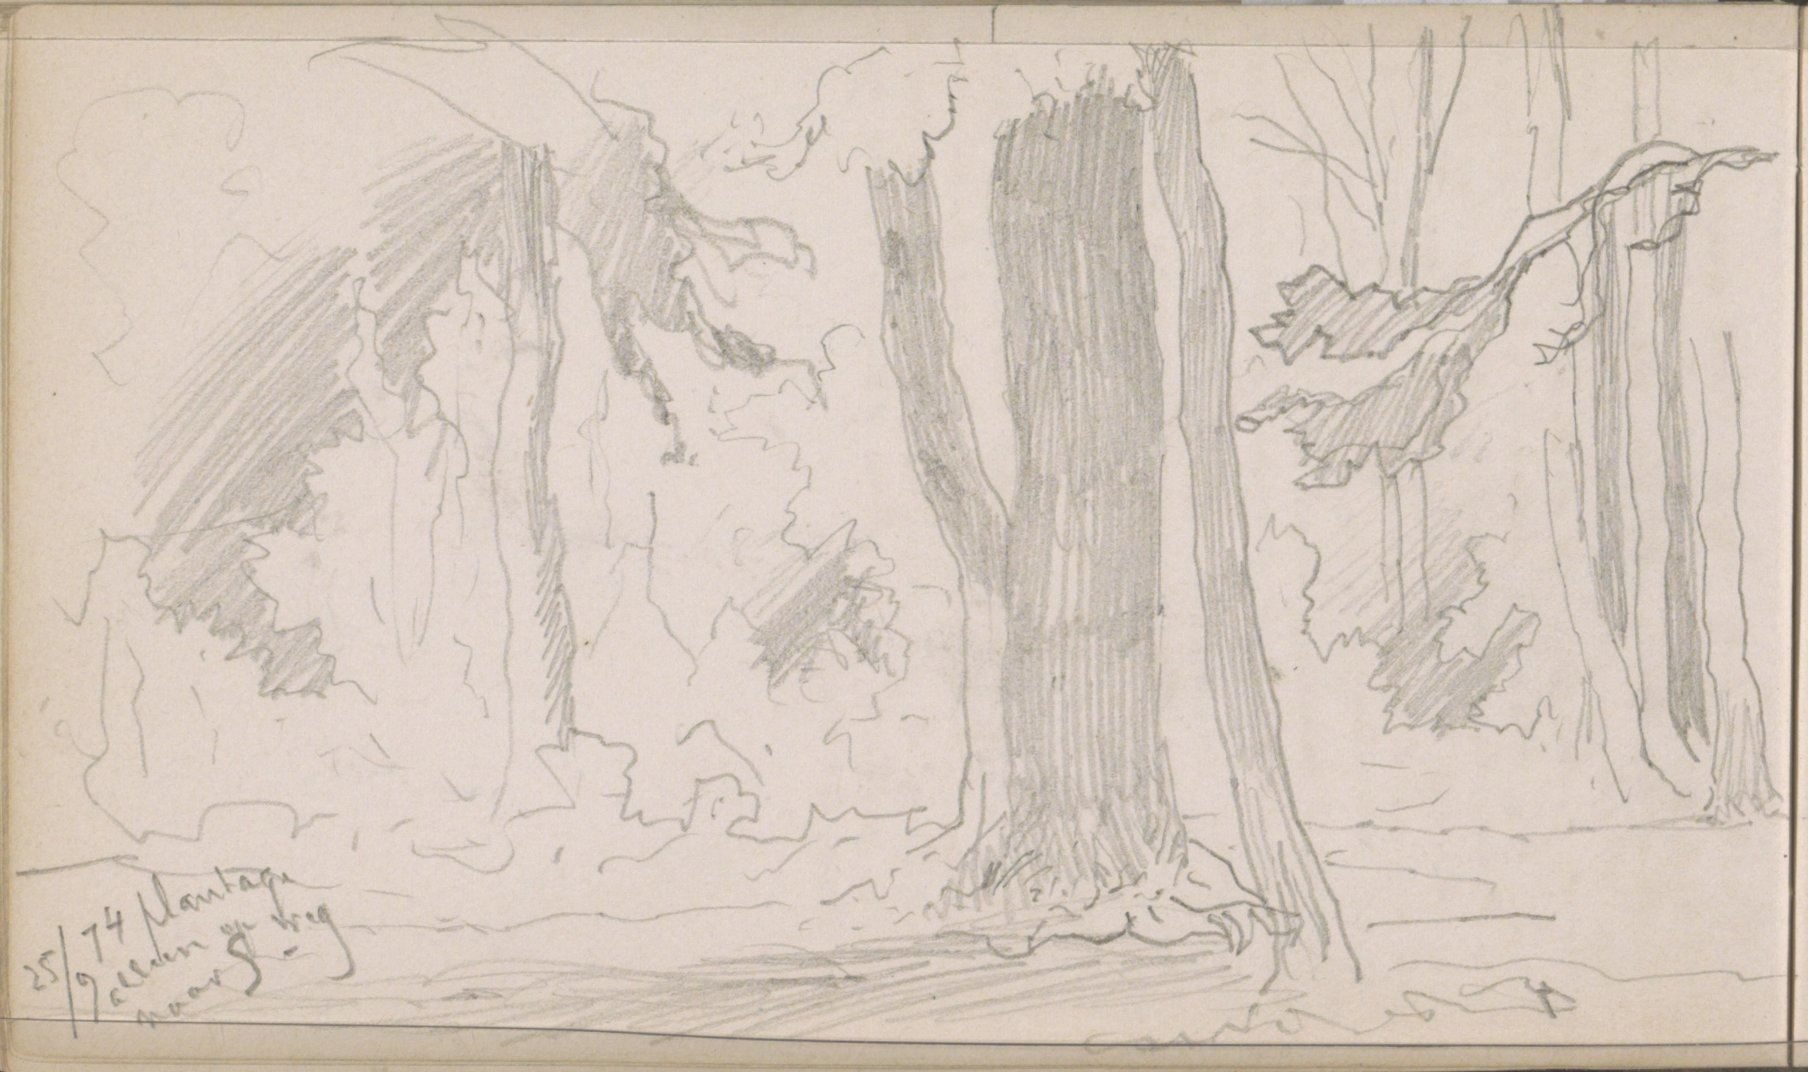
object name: sketchbook leaf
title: Strand bij Scheveningen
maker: johannes tavenraat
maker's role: draughtsman, painter, print maker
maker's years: 1809-1881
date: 1803-1874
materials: paper, pencil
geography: scheveningen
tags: dune coast, sea (seascape)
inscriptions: date and inscription: ‘Scheveningen met Dirk 17/3 74’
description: Blad 29 verso uit een schetsboek met 46 bladen.